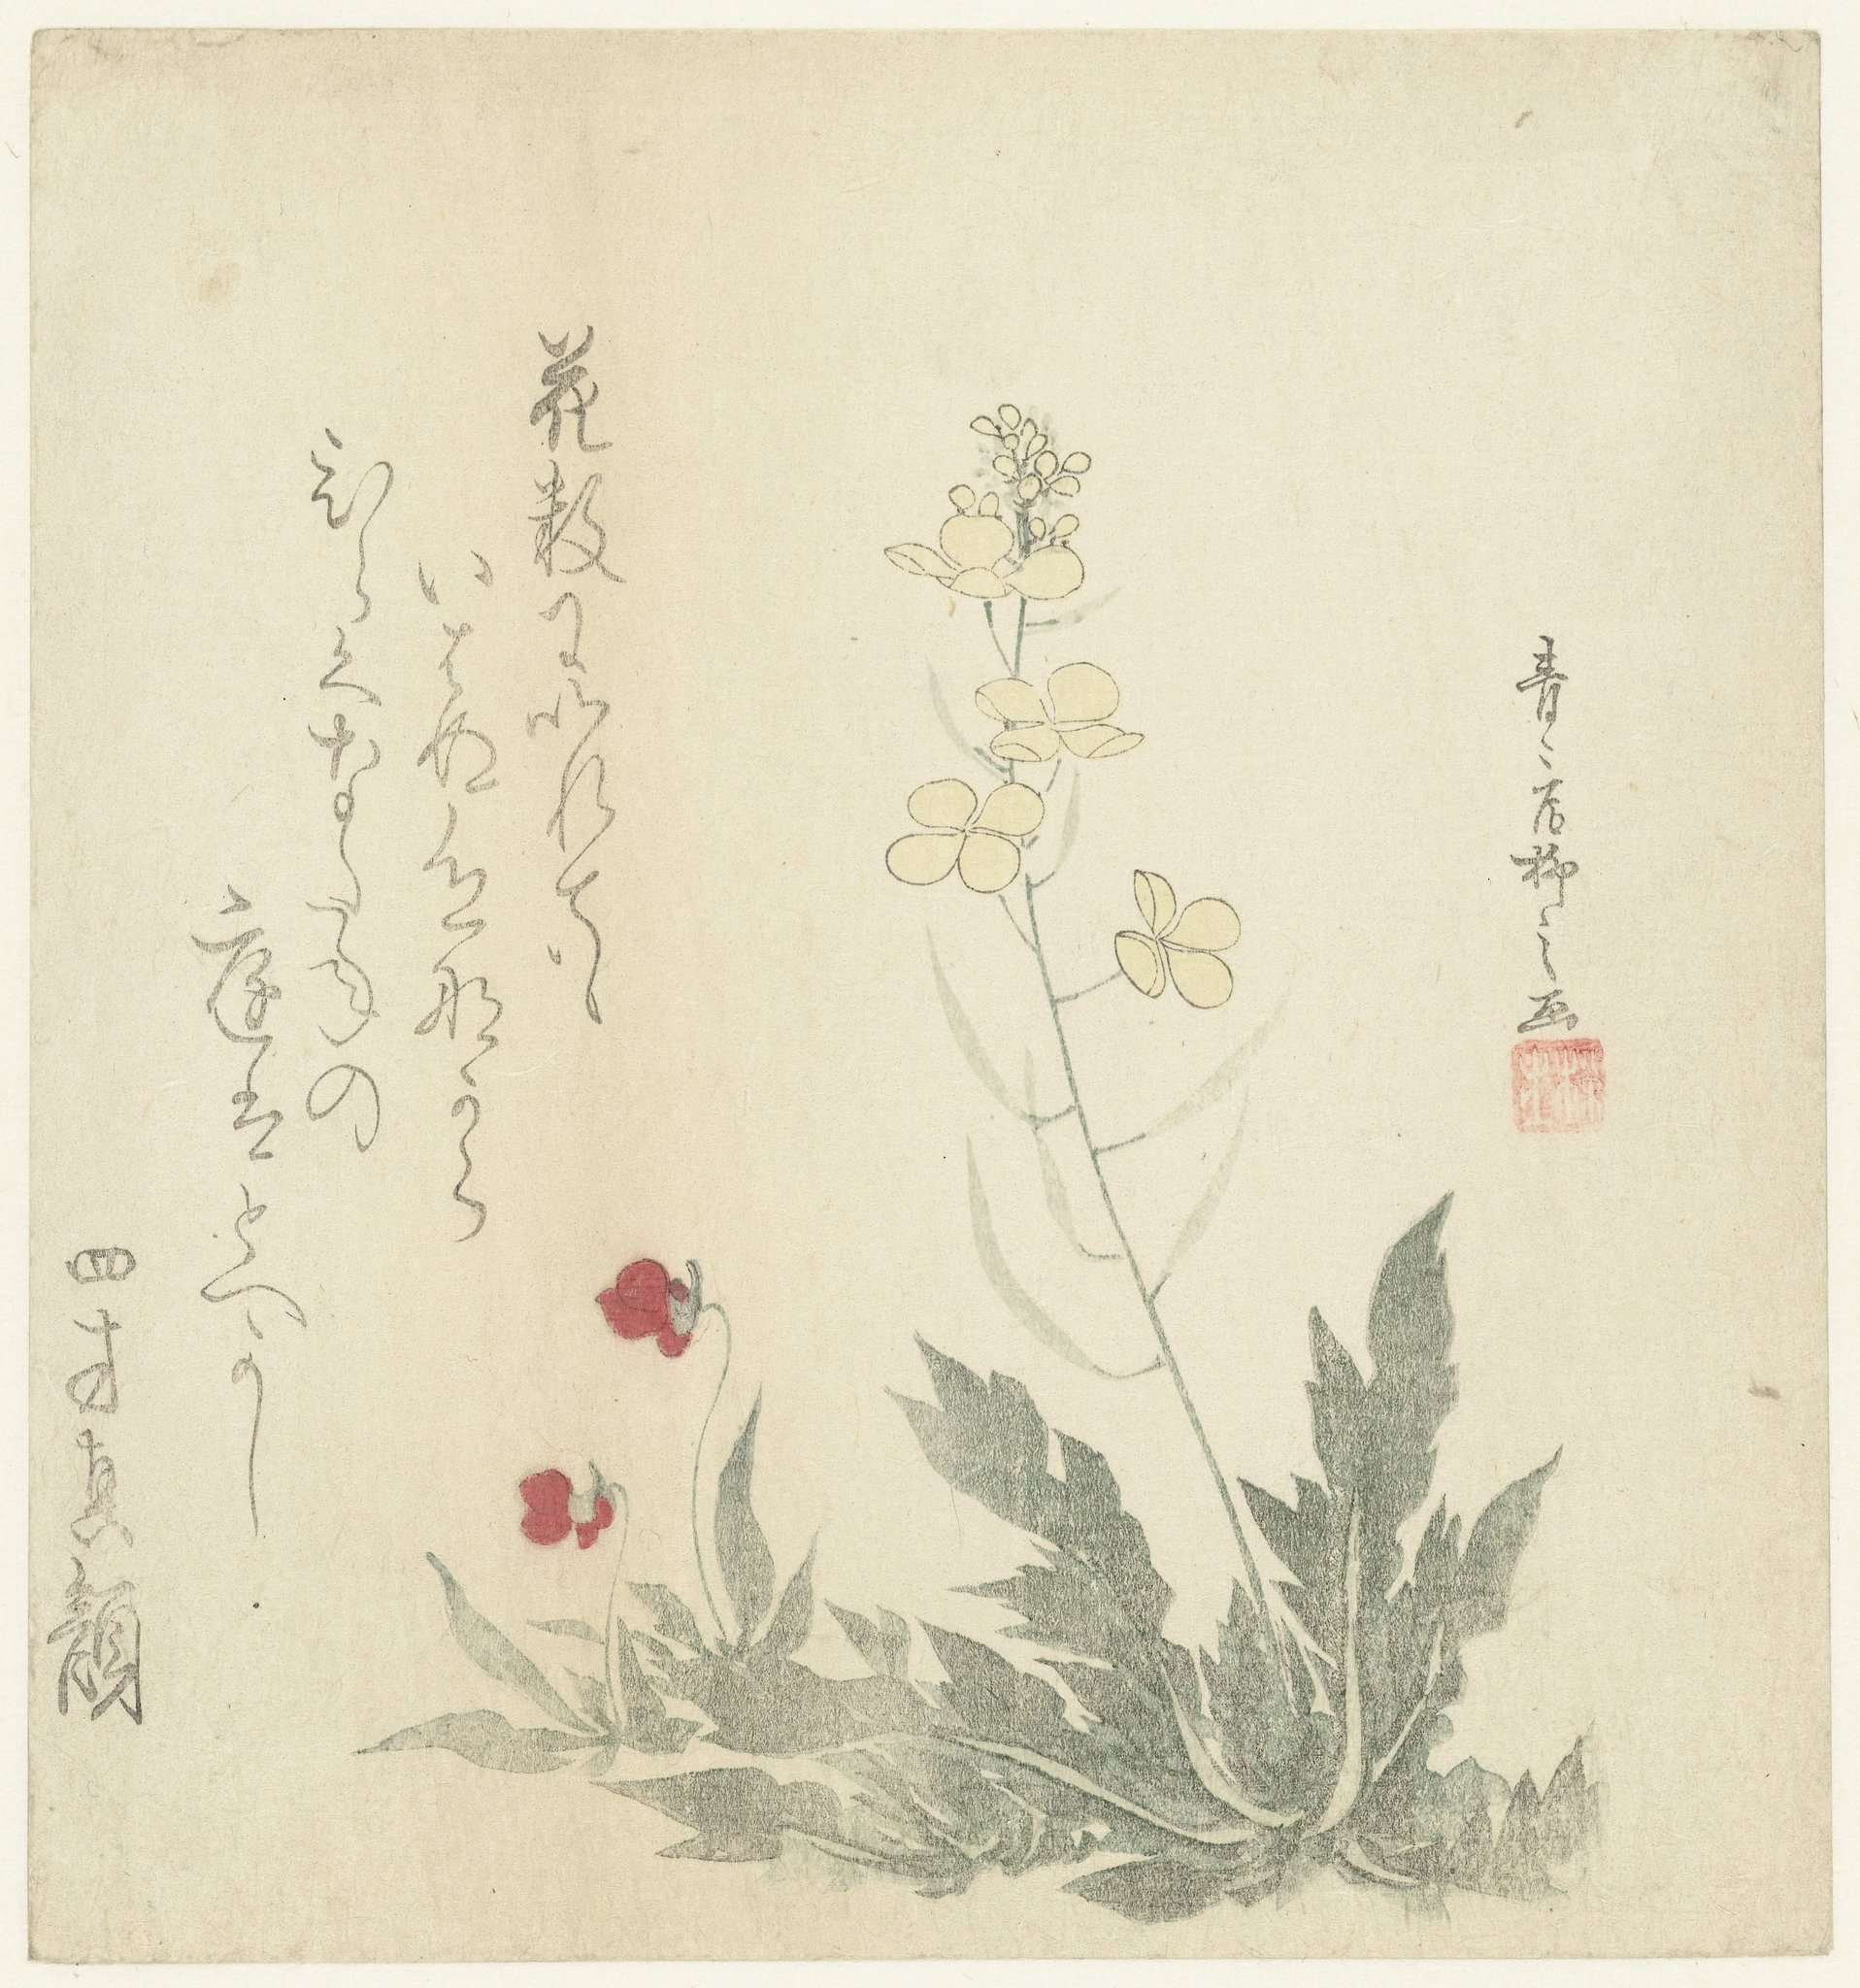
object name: surimono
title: Flowering Plants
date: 1800-1810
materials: paper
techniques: woodcut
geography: japan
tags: flowers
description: Een surimono is een luxe uitgevoerde prent waarop beeld met één of meerdere gedichten gecombineerd is. Bij het drukken van een surimono werd vaak gebruik gemaakt van dikker papier, blinddruk en metaal pigmenten, zoals koper- en zilverpoeder. De prenten werden vaak in opdracht van dichters gemaakt en als exclusief geschenk aan vrienden en relaties gegeven.